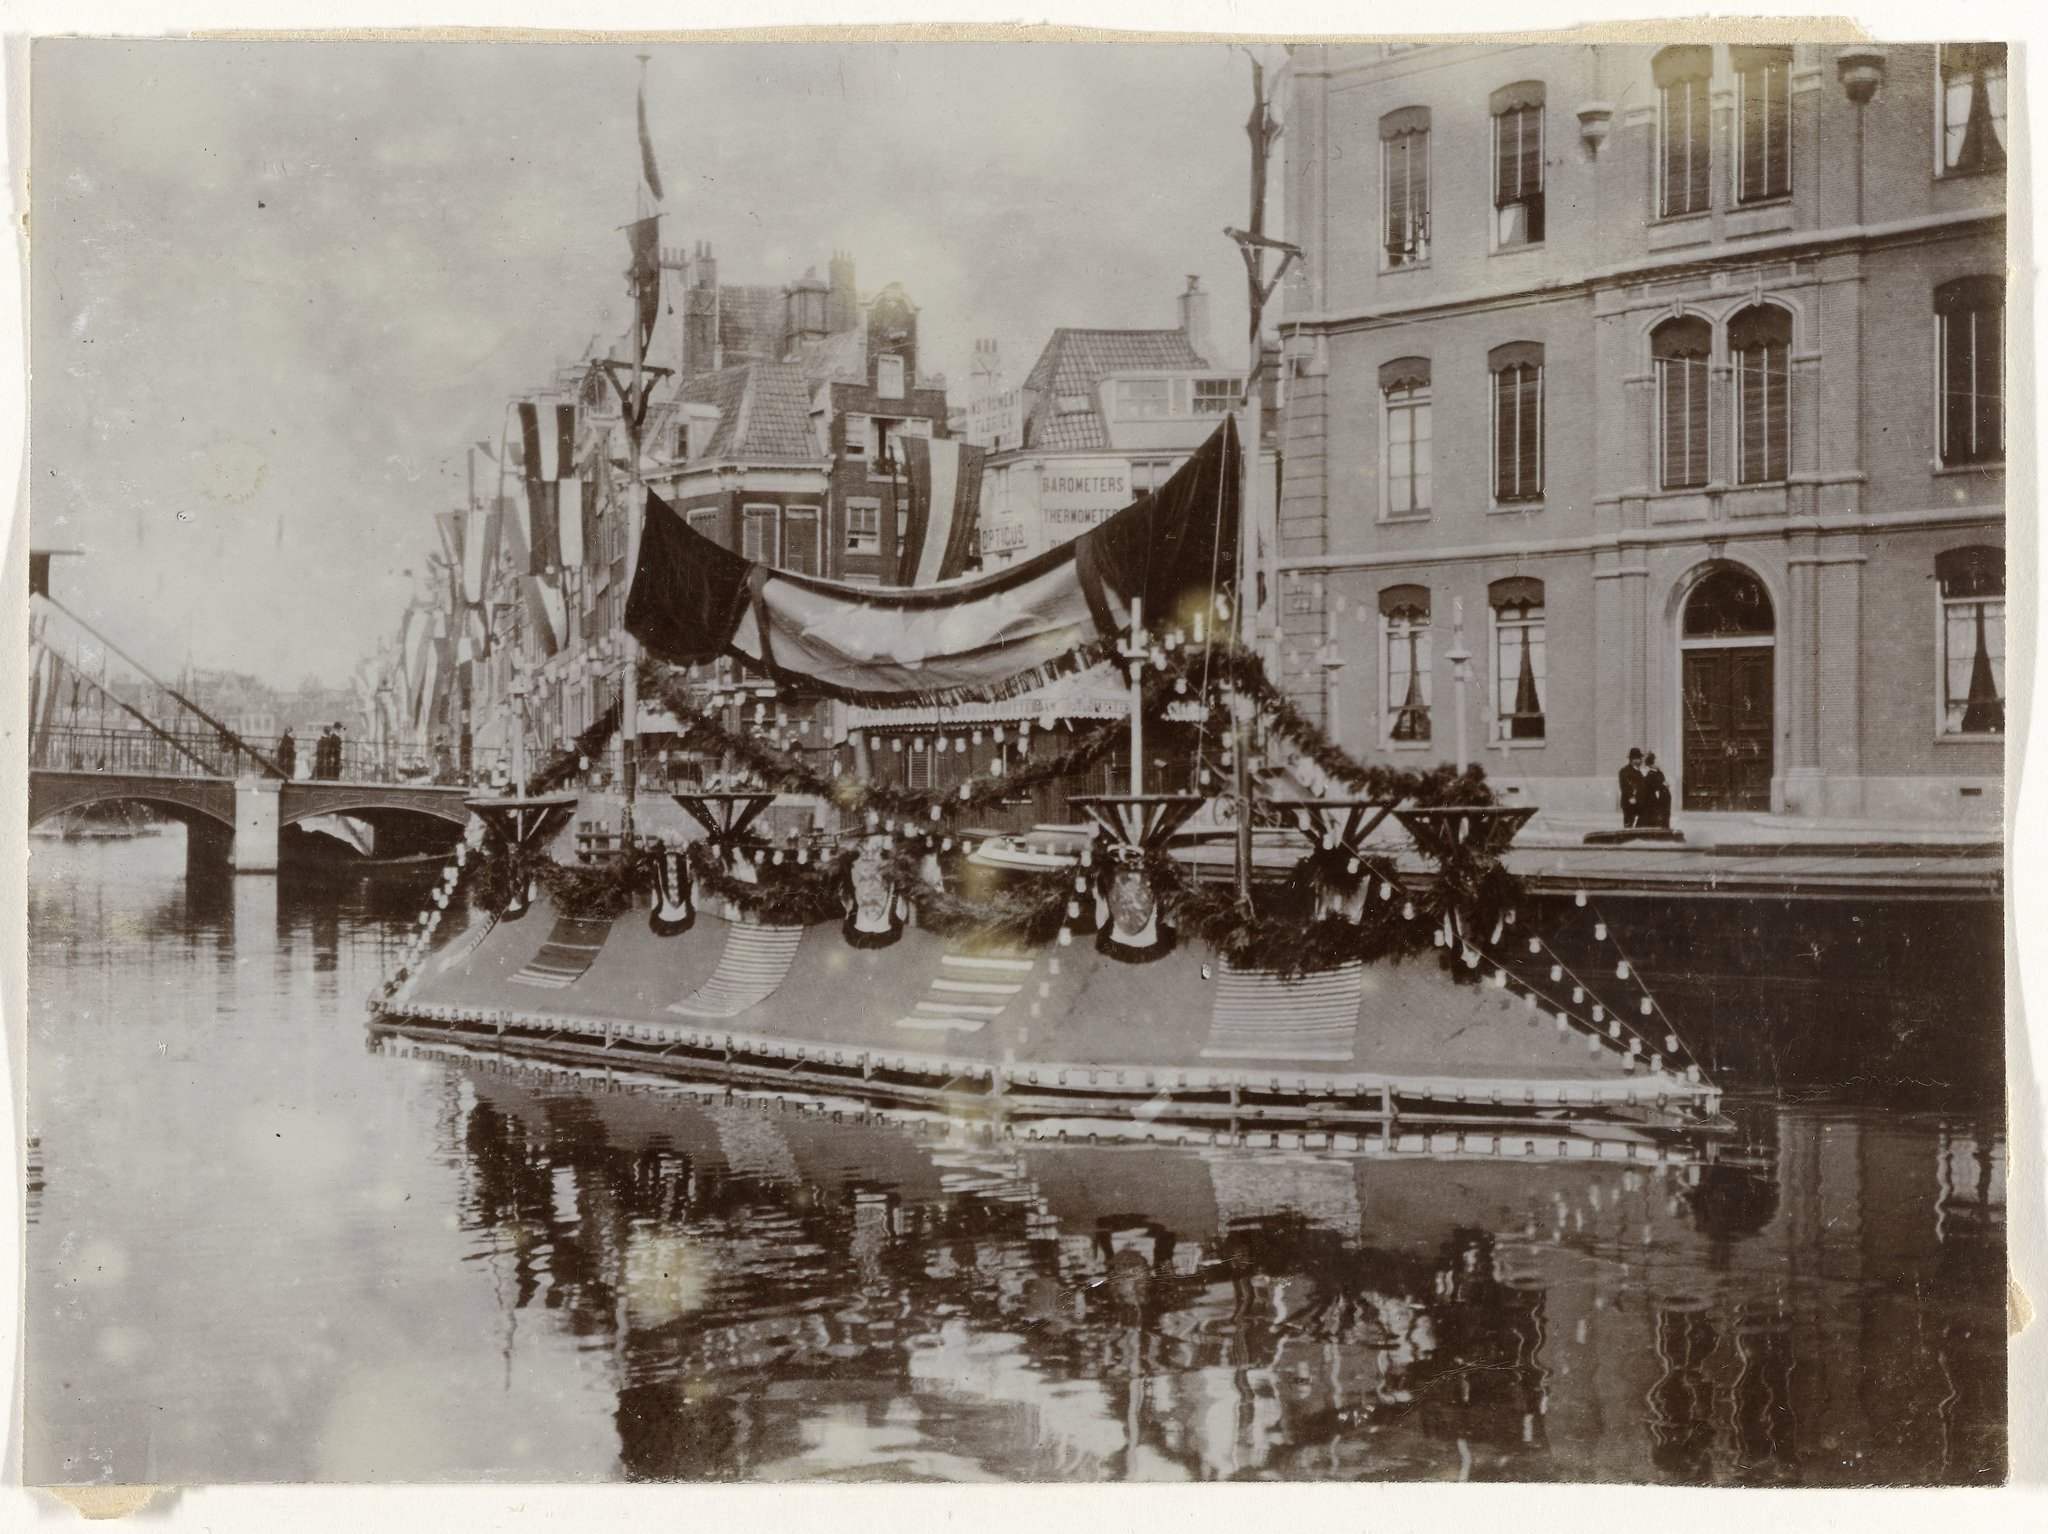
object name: photograph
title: Versierde boot in het Rokin ter gelegenheid van de inhuldiging van koningin Wilhelmina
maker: Anonymous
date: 1809-1898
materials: paper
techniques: collodion silver print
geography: amsterdam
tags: public festivities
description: Een versierde roeiboot in het Rokin, ter gelegenheid van de inhuldiging van koningin Wilhelmina. De boot ligt bij de Oude Turfmarkt nabij de Grimnessersluis en de Langebrugsteeg.